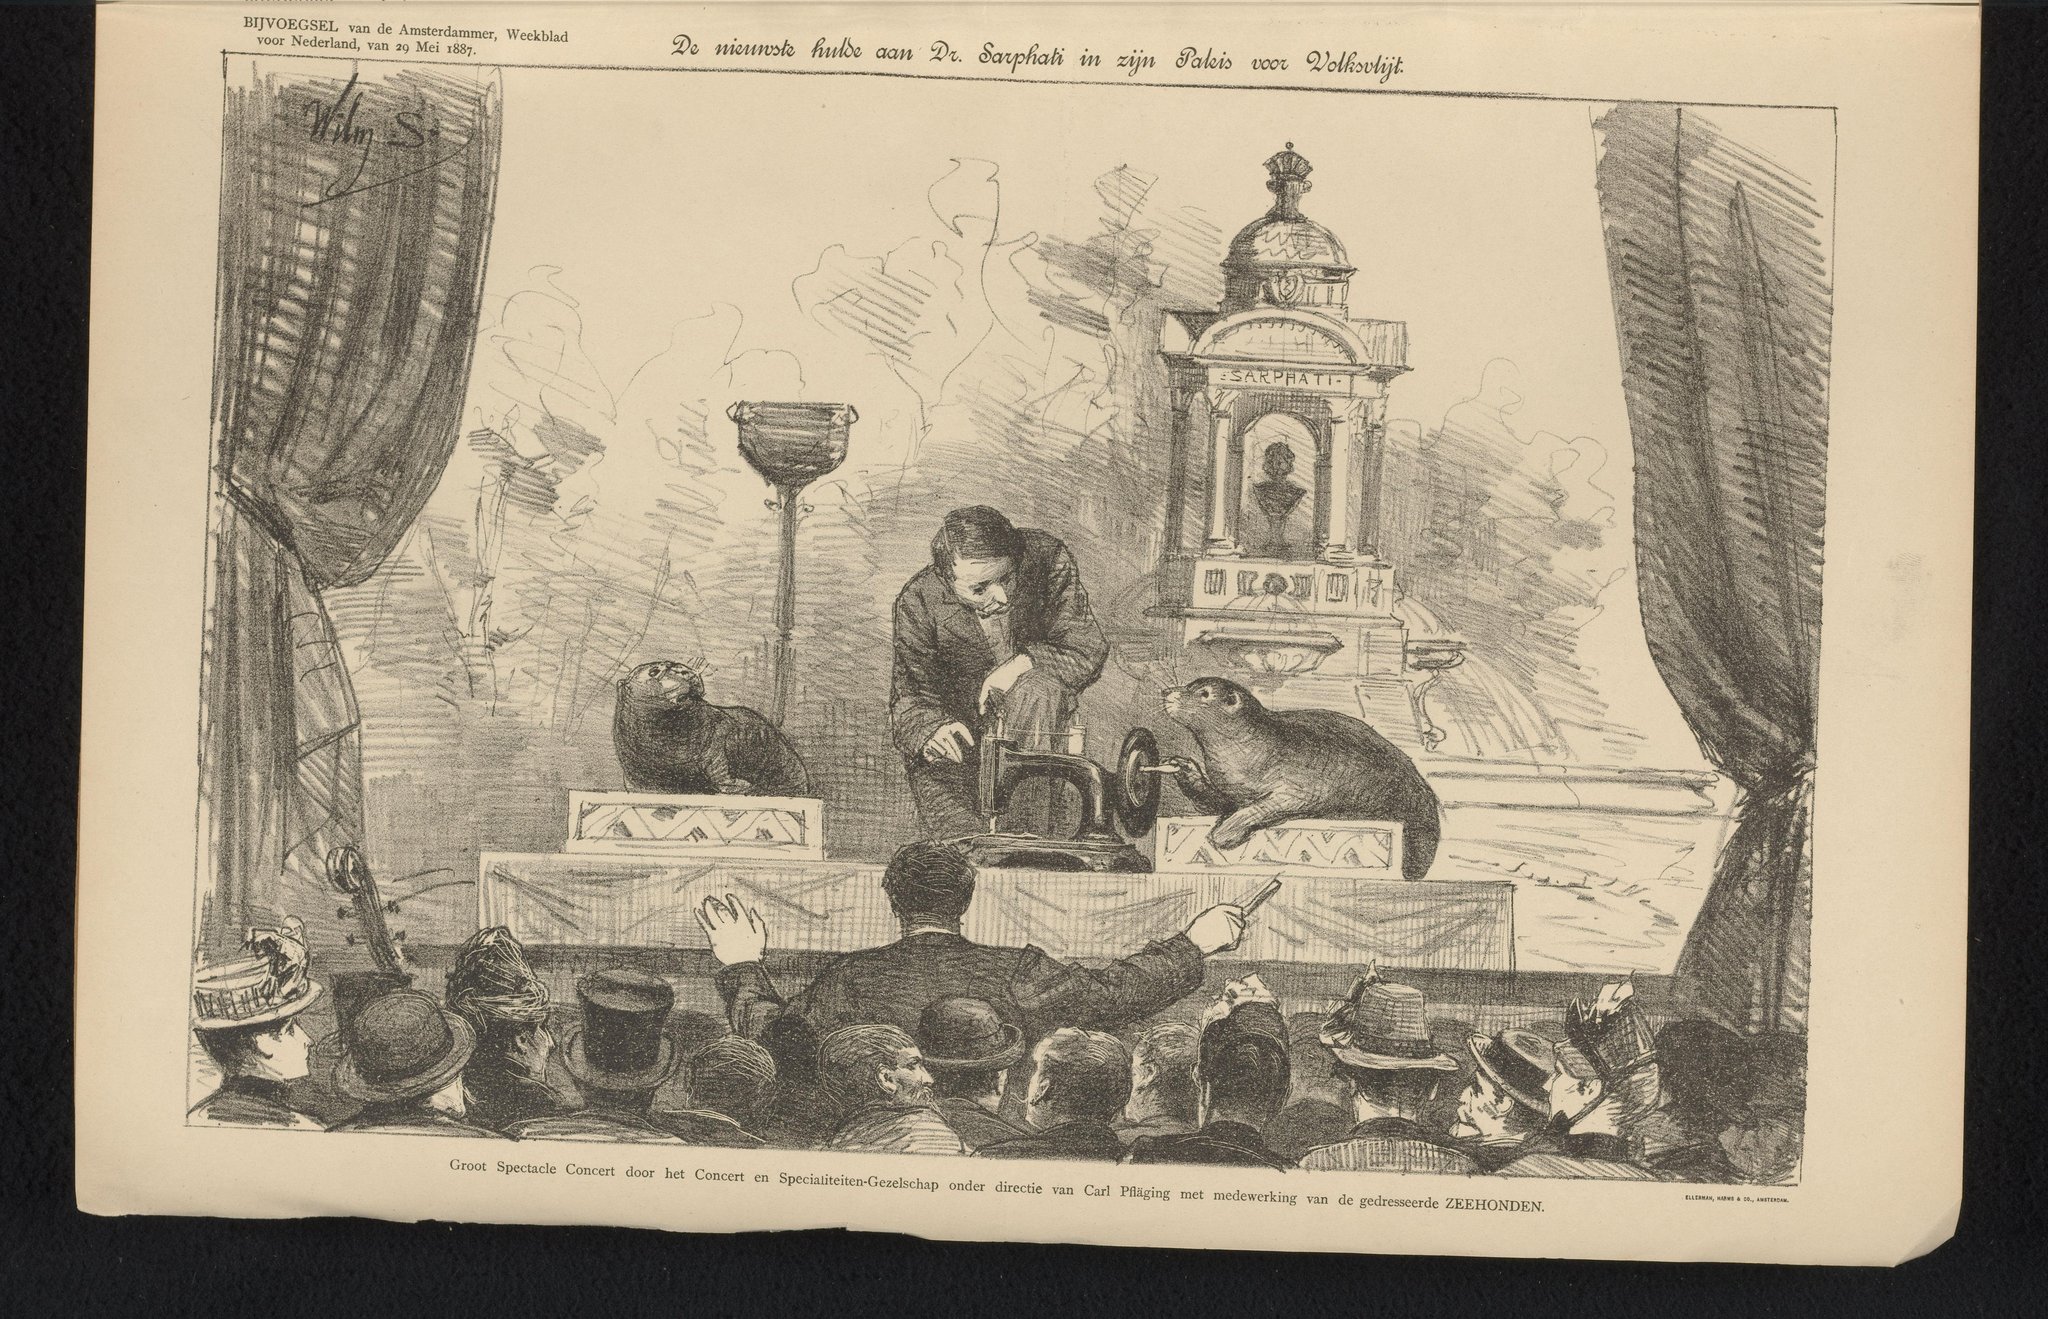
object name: cartoon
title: De nieuwste hulde aan Dr. Sarphati in zijn Paleis voor Volksvlijt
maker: willem steelink (ii)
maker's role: draughtsman, print maker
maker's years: 1856-1928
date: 1887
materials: paper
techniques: lithograph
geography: netherlands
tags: rotterdam, amsterdam, samuel sarphati, circus animals, sewing machine, seals (circus performance), swimming mammals: seal, political caricatures and satires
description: Hulde gebracht aan dr. Samuel Sarphati in het Paleis voor Volksvlijt met een opvoering door twee gedresseerde zeehonden met een naaimachine, onder leiding van Carl Pfläging. Op de achtergrond het Sarphatimonument.